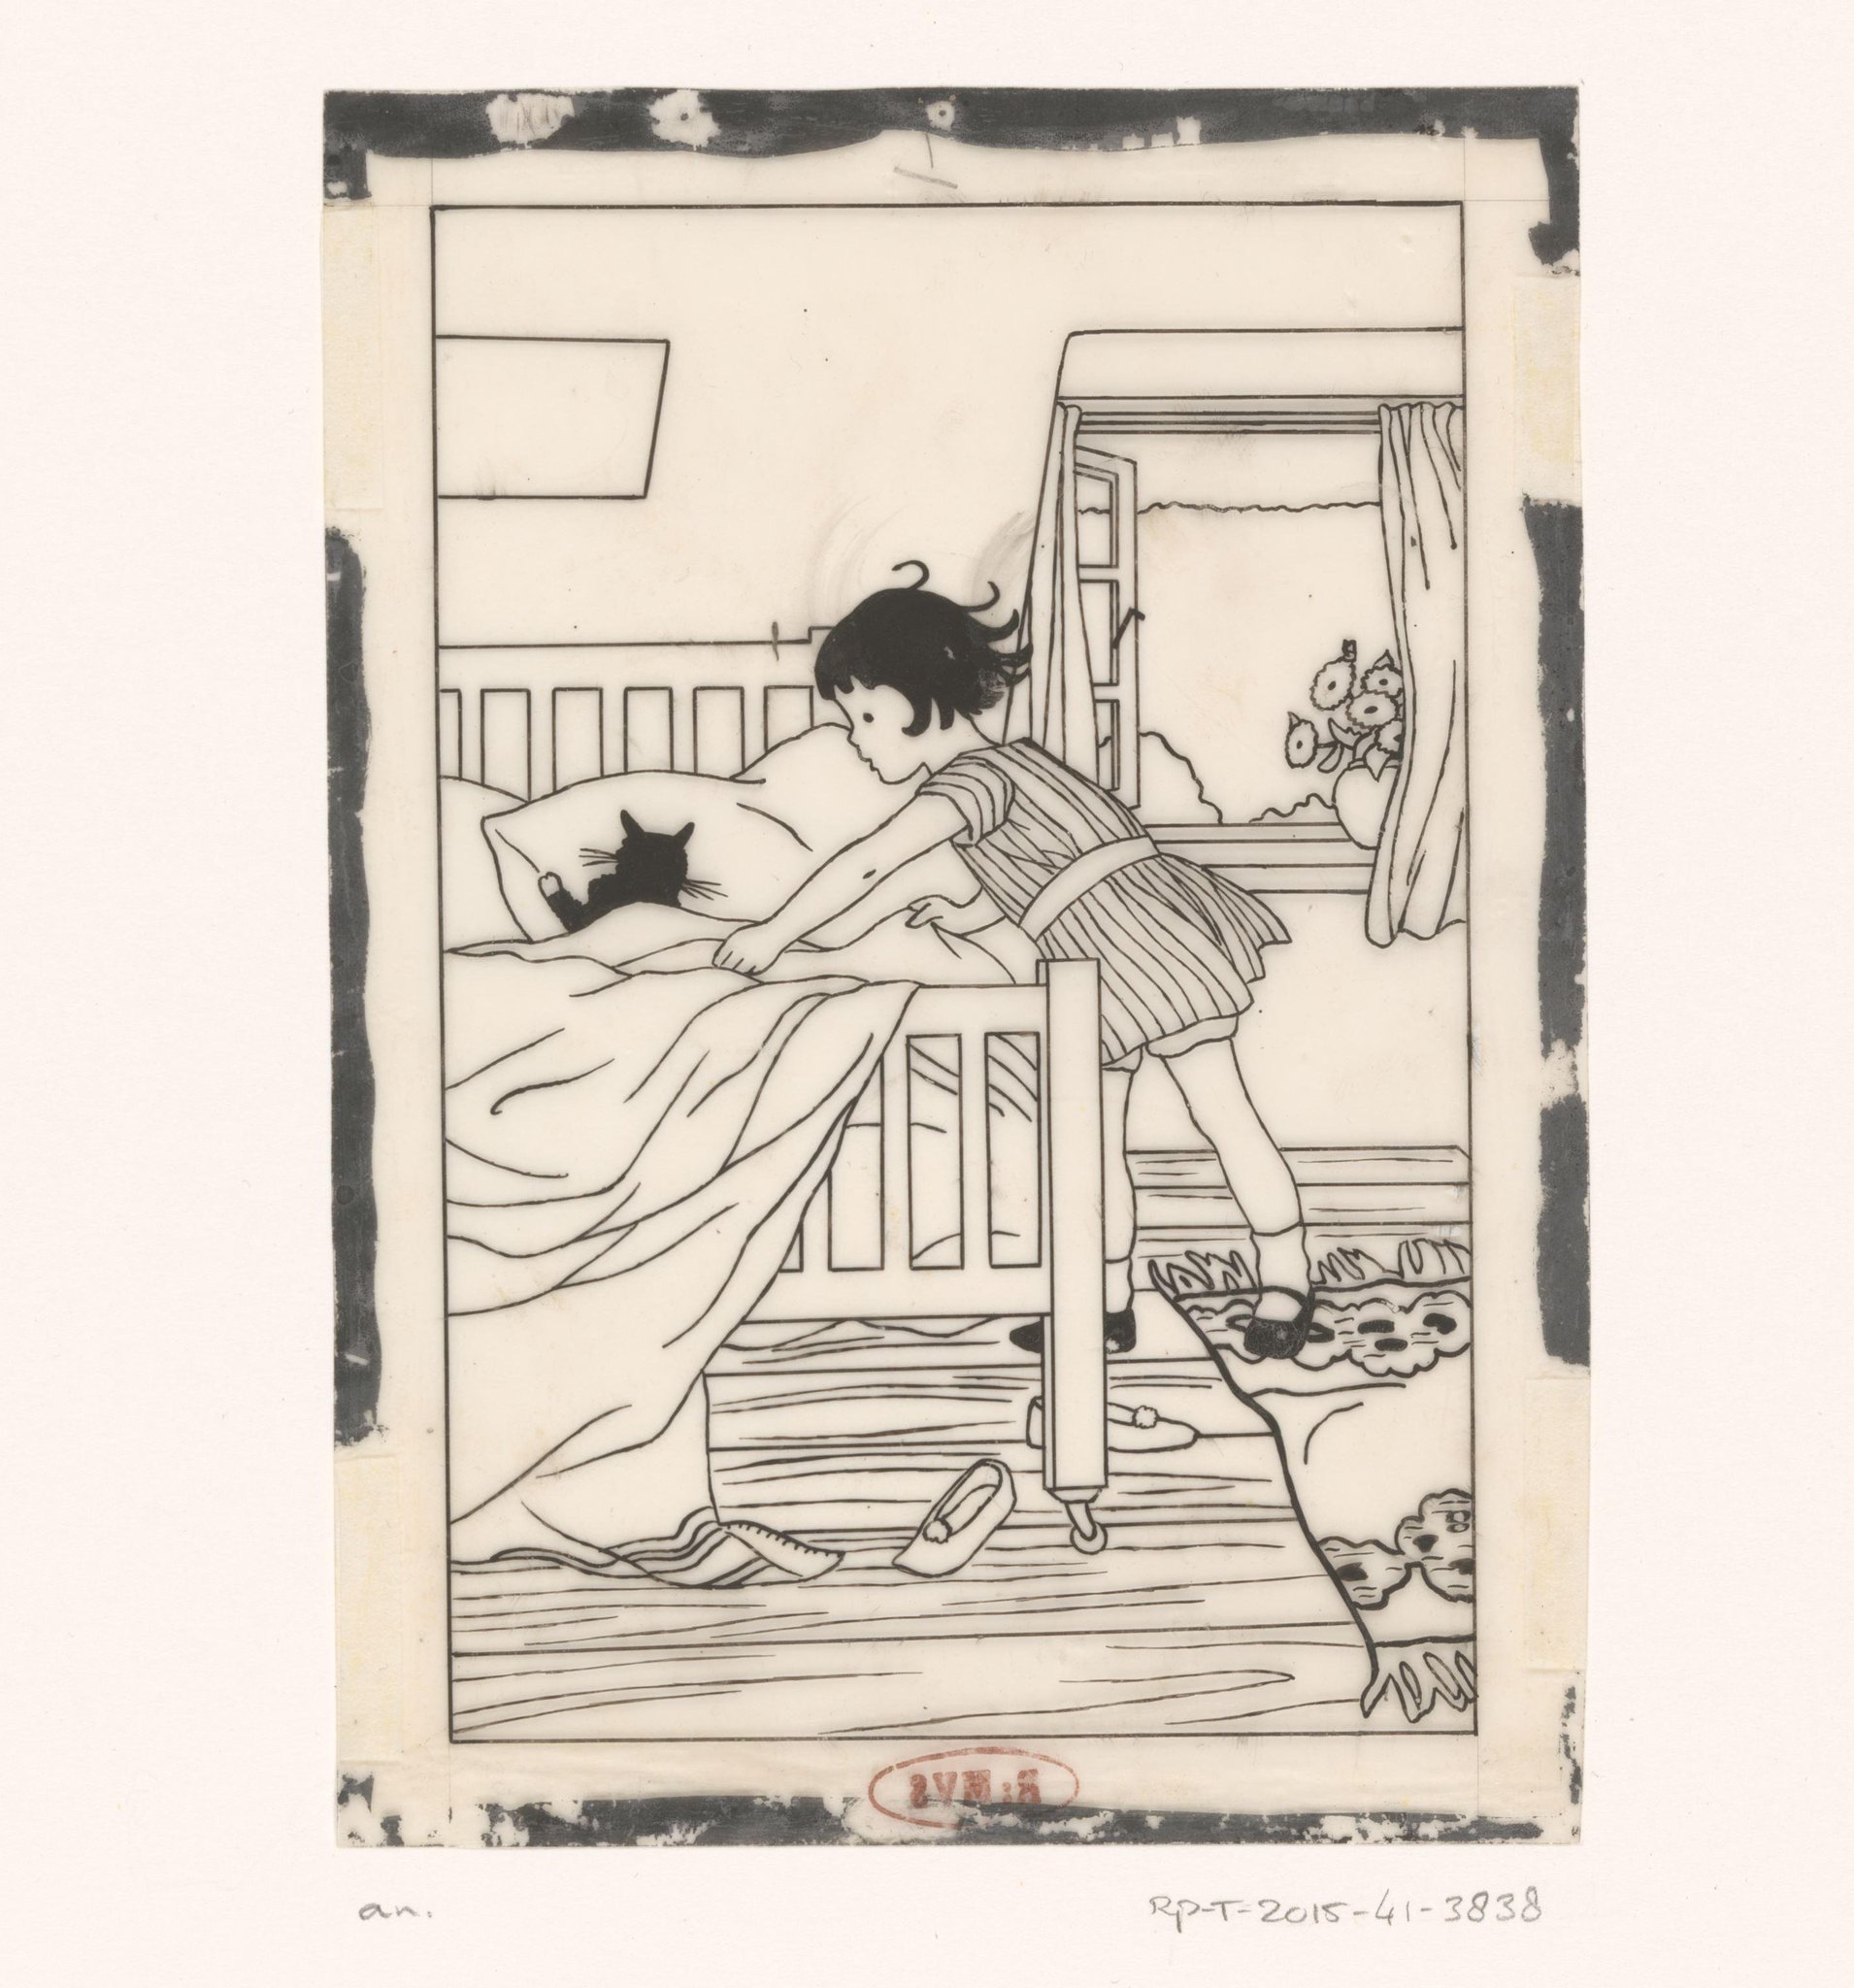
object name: boekillustratie ontwerp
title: Meisje vindt een kat in bed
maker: Anonymous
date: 1900-1930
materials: paint, ink, paper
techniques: brush, pen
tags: cat, bed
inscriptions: number: ‘I’, collector's mark: Lugt 2228a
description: In een slaapkamer staat een meisje naast een bed. Ze trekt de dekens weg zodat een kat die in het bed ligt tevoorschijn komt.